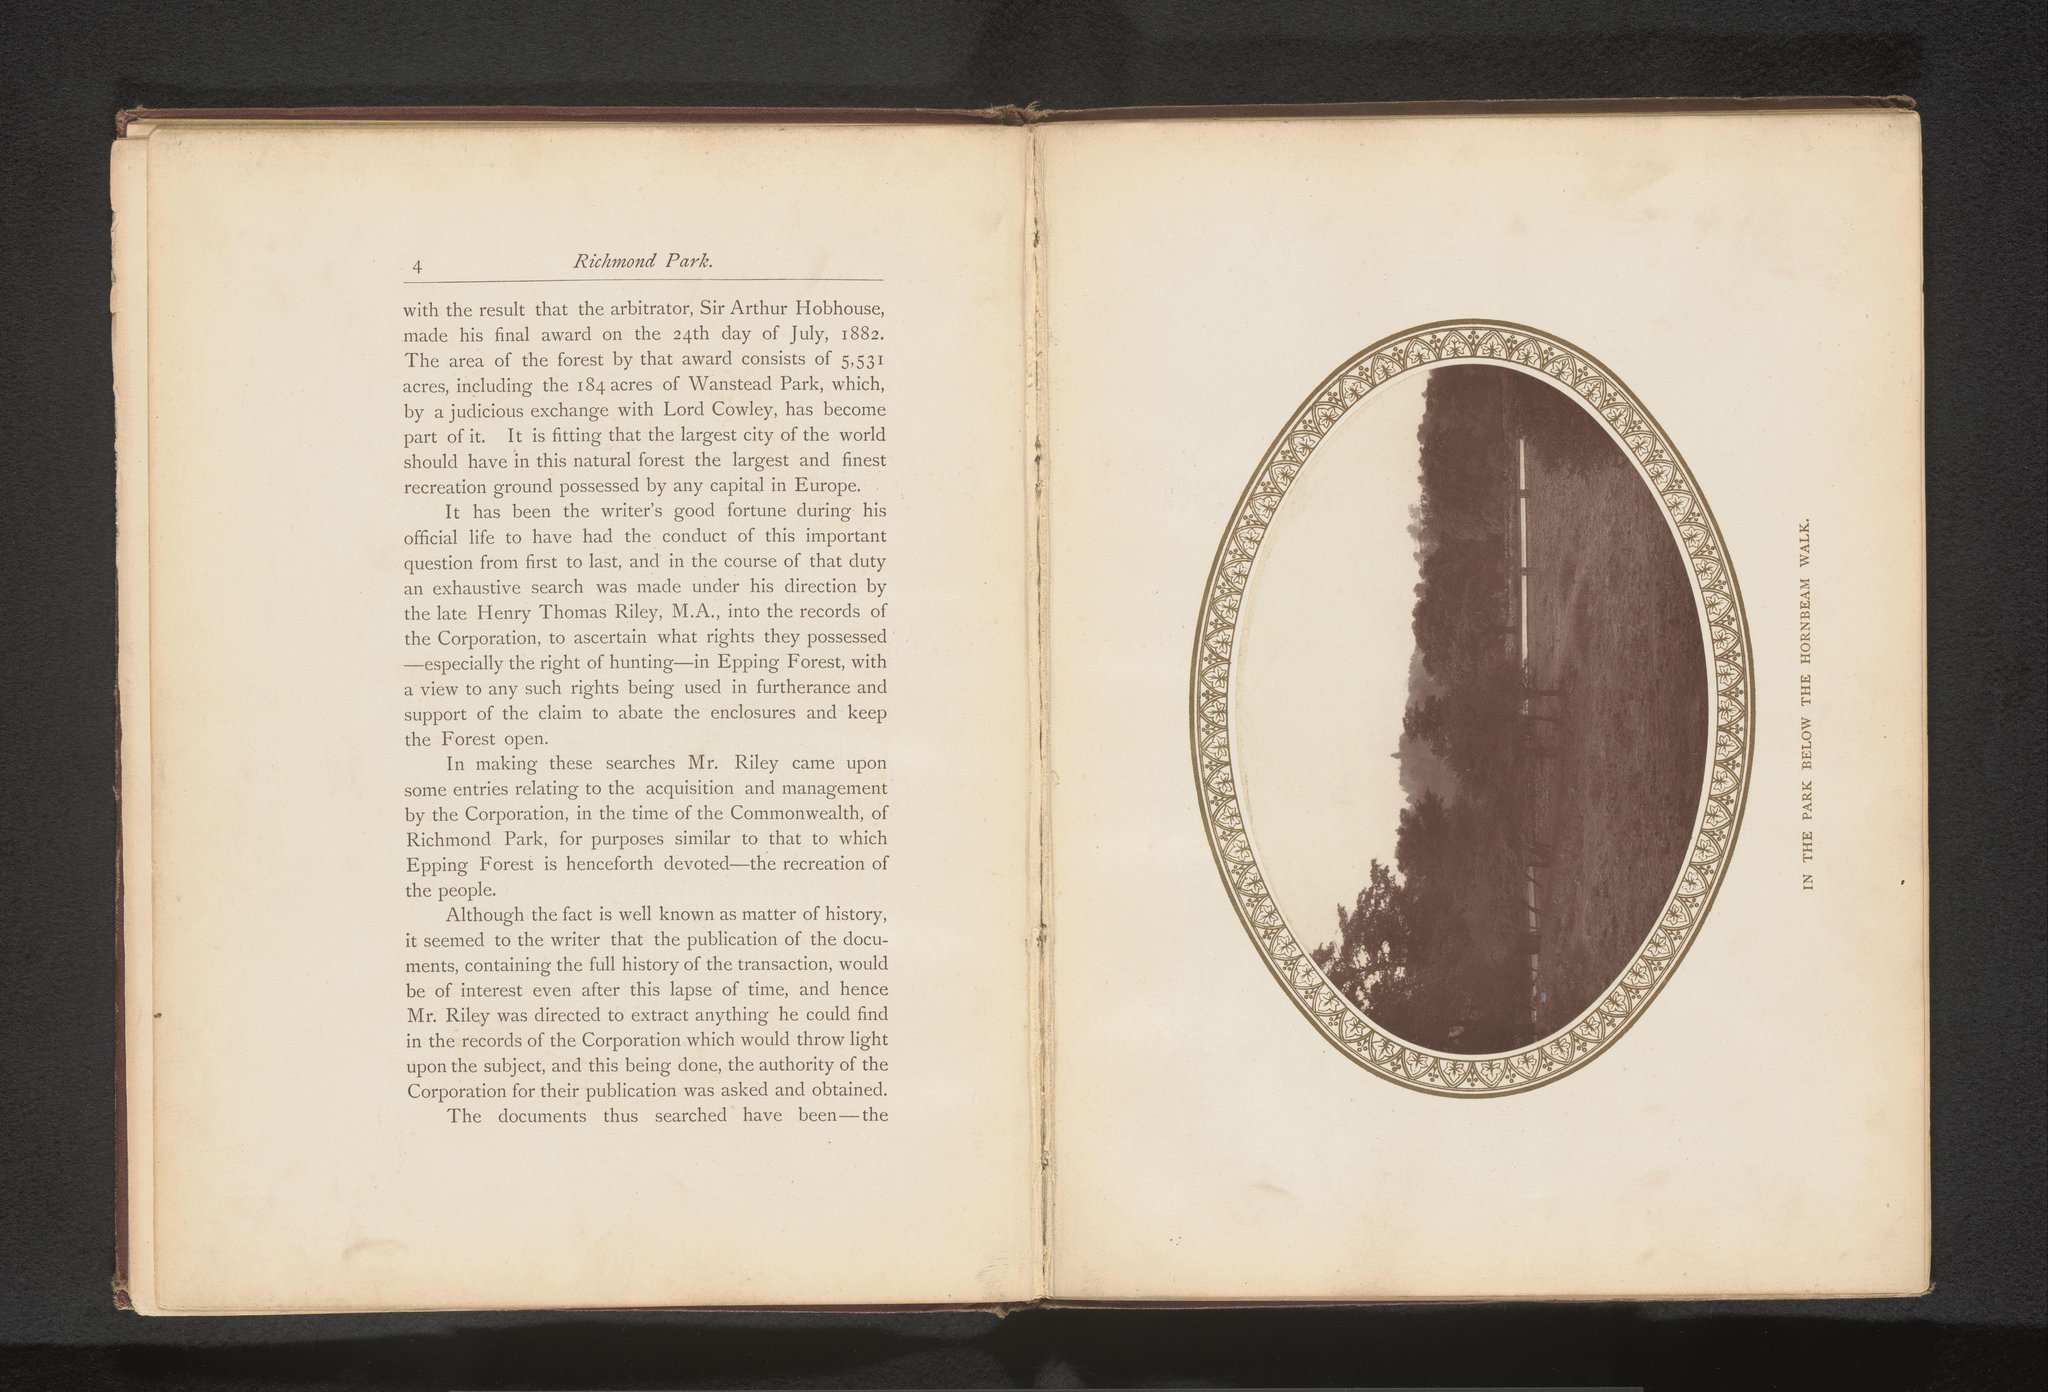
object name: page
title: In the Park below the Hornbeam Walk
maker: Anonymous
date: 1879-1889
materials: paper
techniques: woodburytype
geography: richmond park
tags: public gardens, park